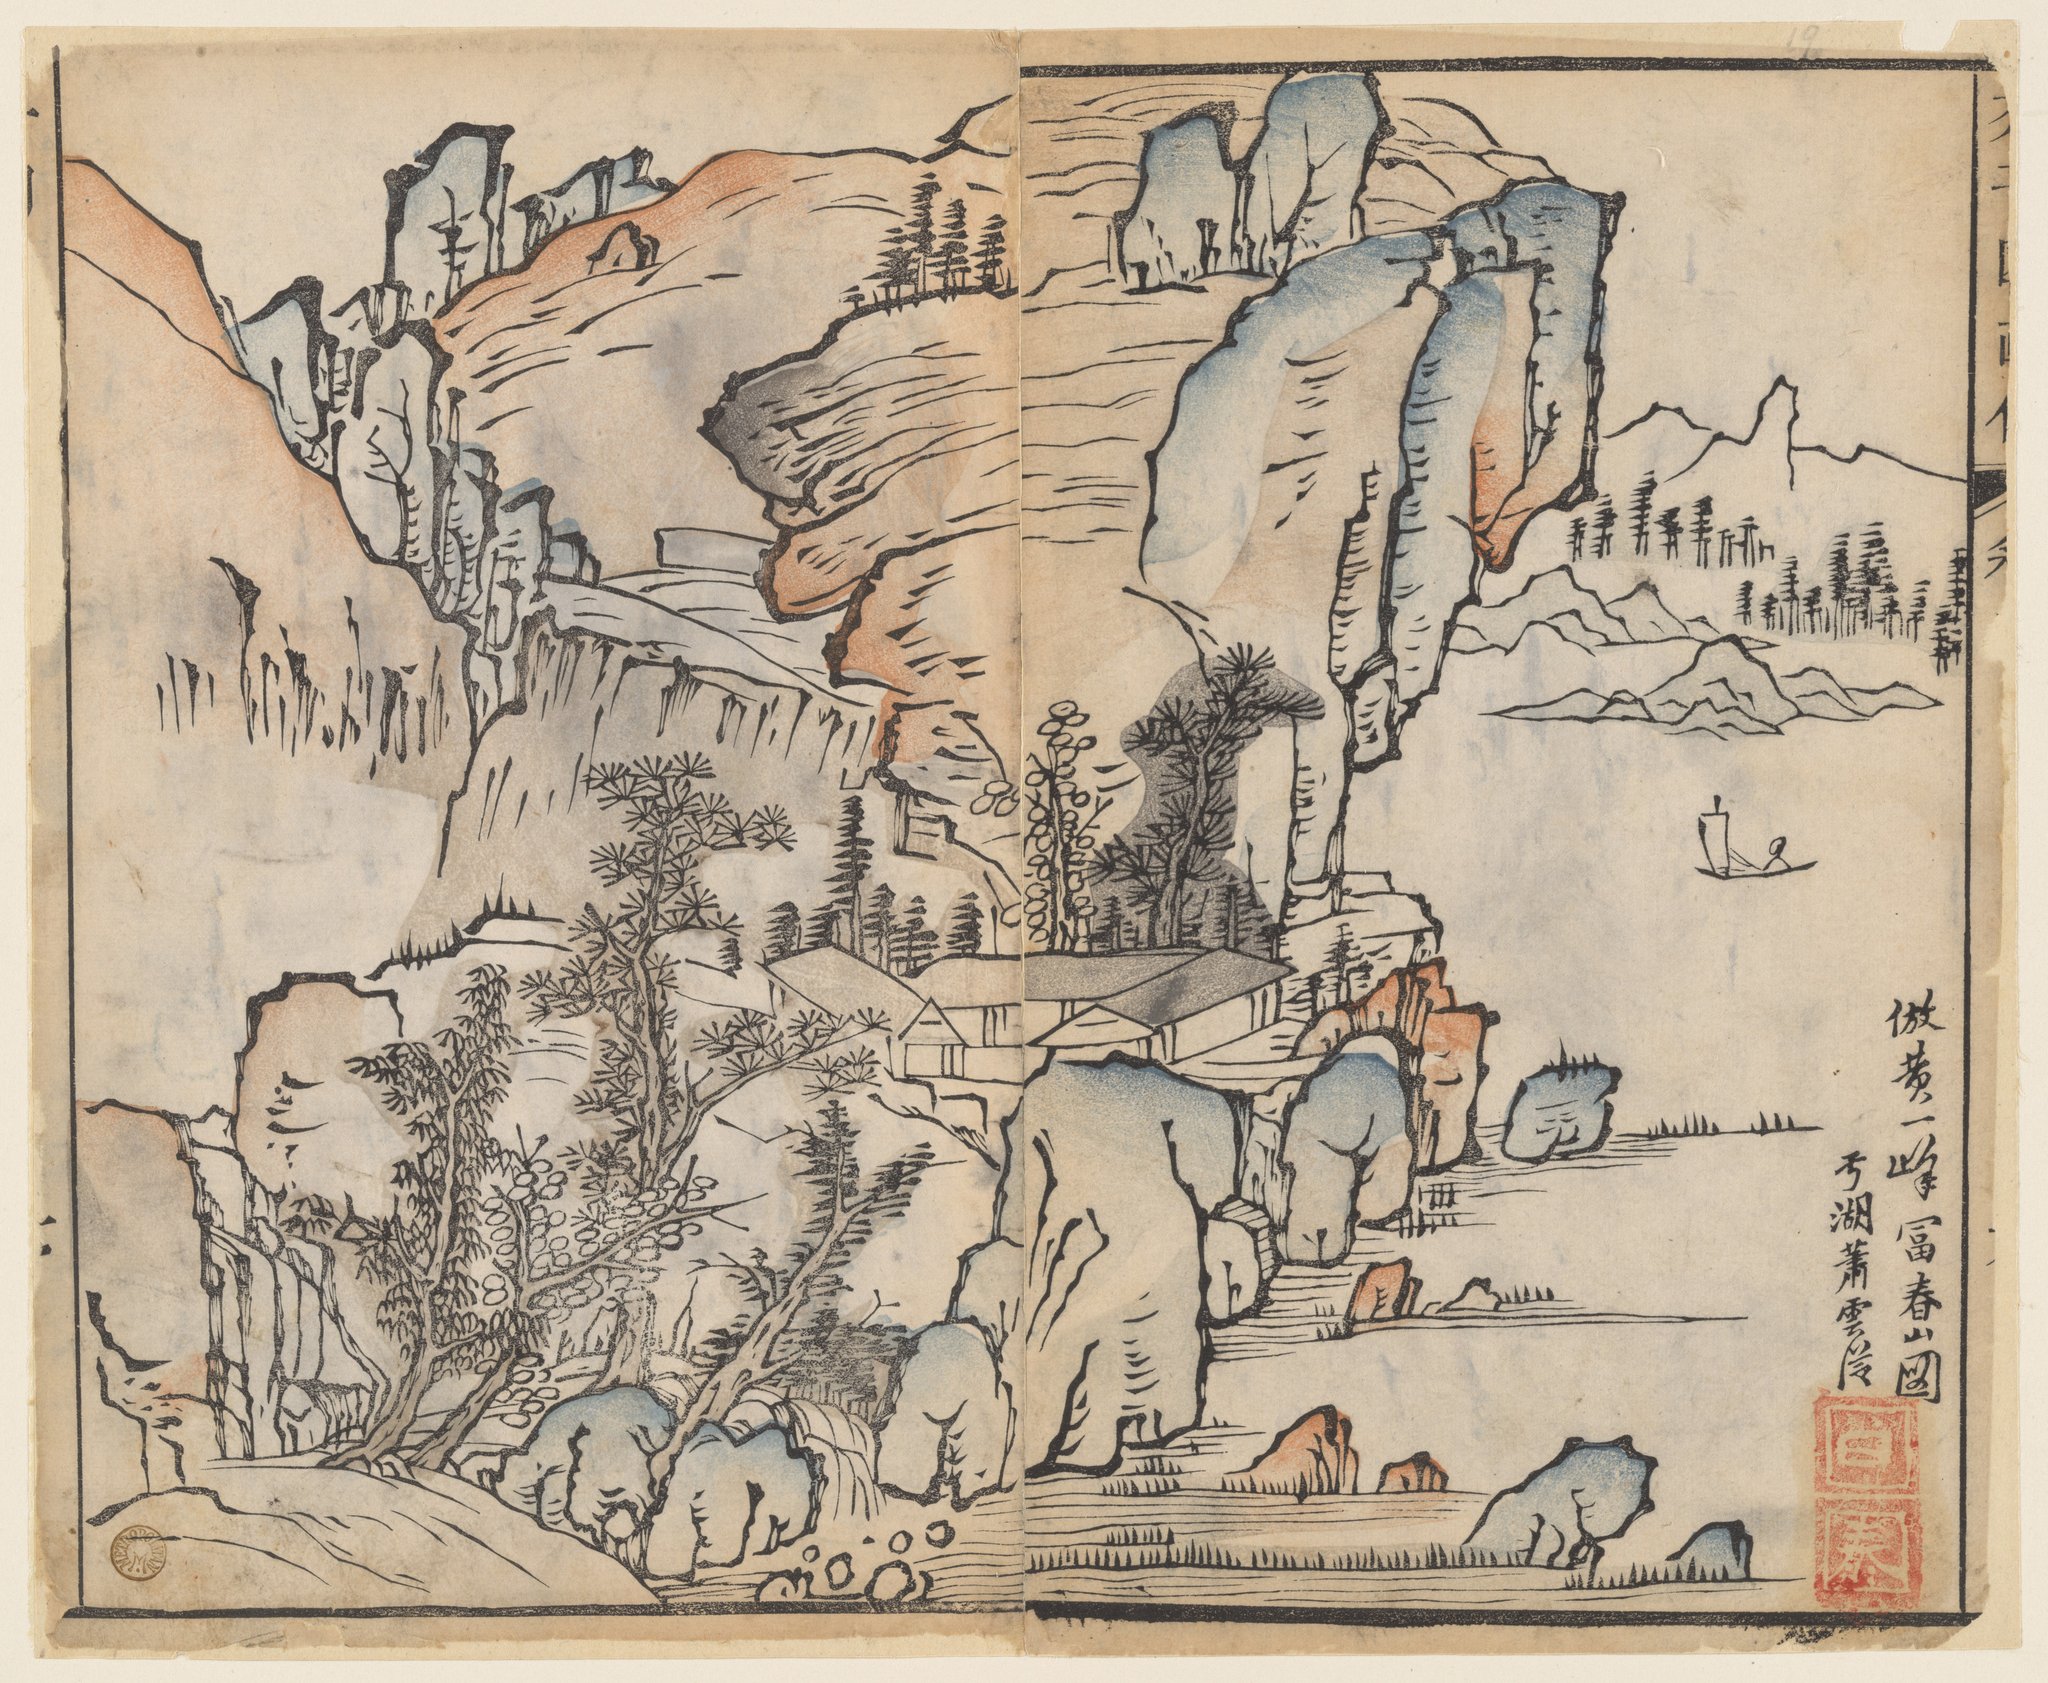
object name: print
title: Page from the Mustard Seed Garden Manual of Painting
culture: chinese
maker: wang gai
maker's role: artist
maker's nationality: chinese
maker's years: 1645-1710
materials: ink, paper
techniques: woodblock print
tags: mountains,landscapes